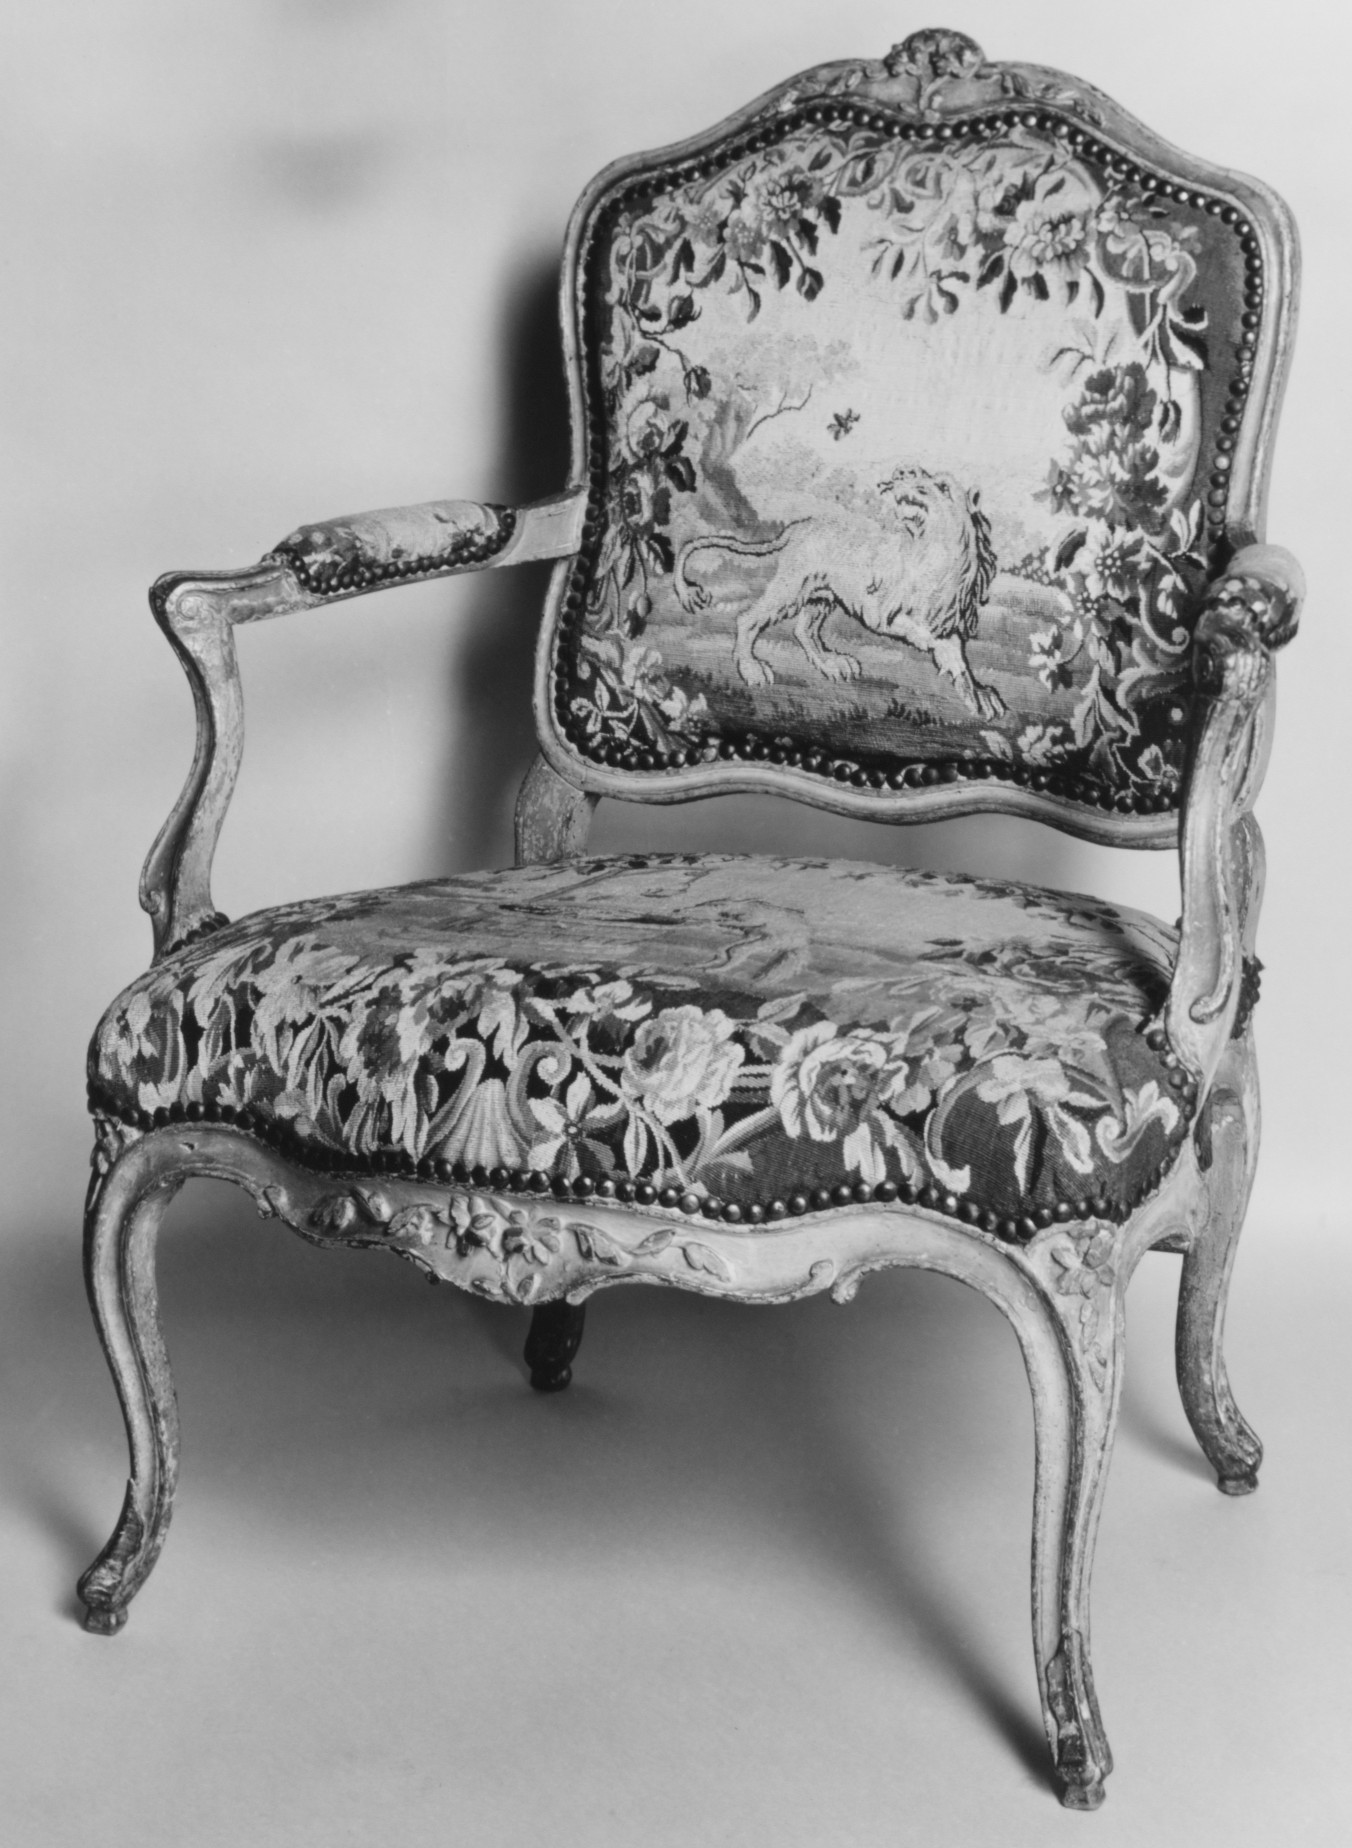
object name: armchair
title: Armchair (part of a set of nine)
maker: aubusson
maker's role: factory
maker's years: 1665-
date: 1734-1766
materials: wood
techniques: carving, painting, tapestry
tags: animals,flowers